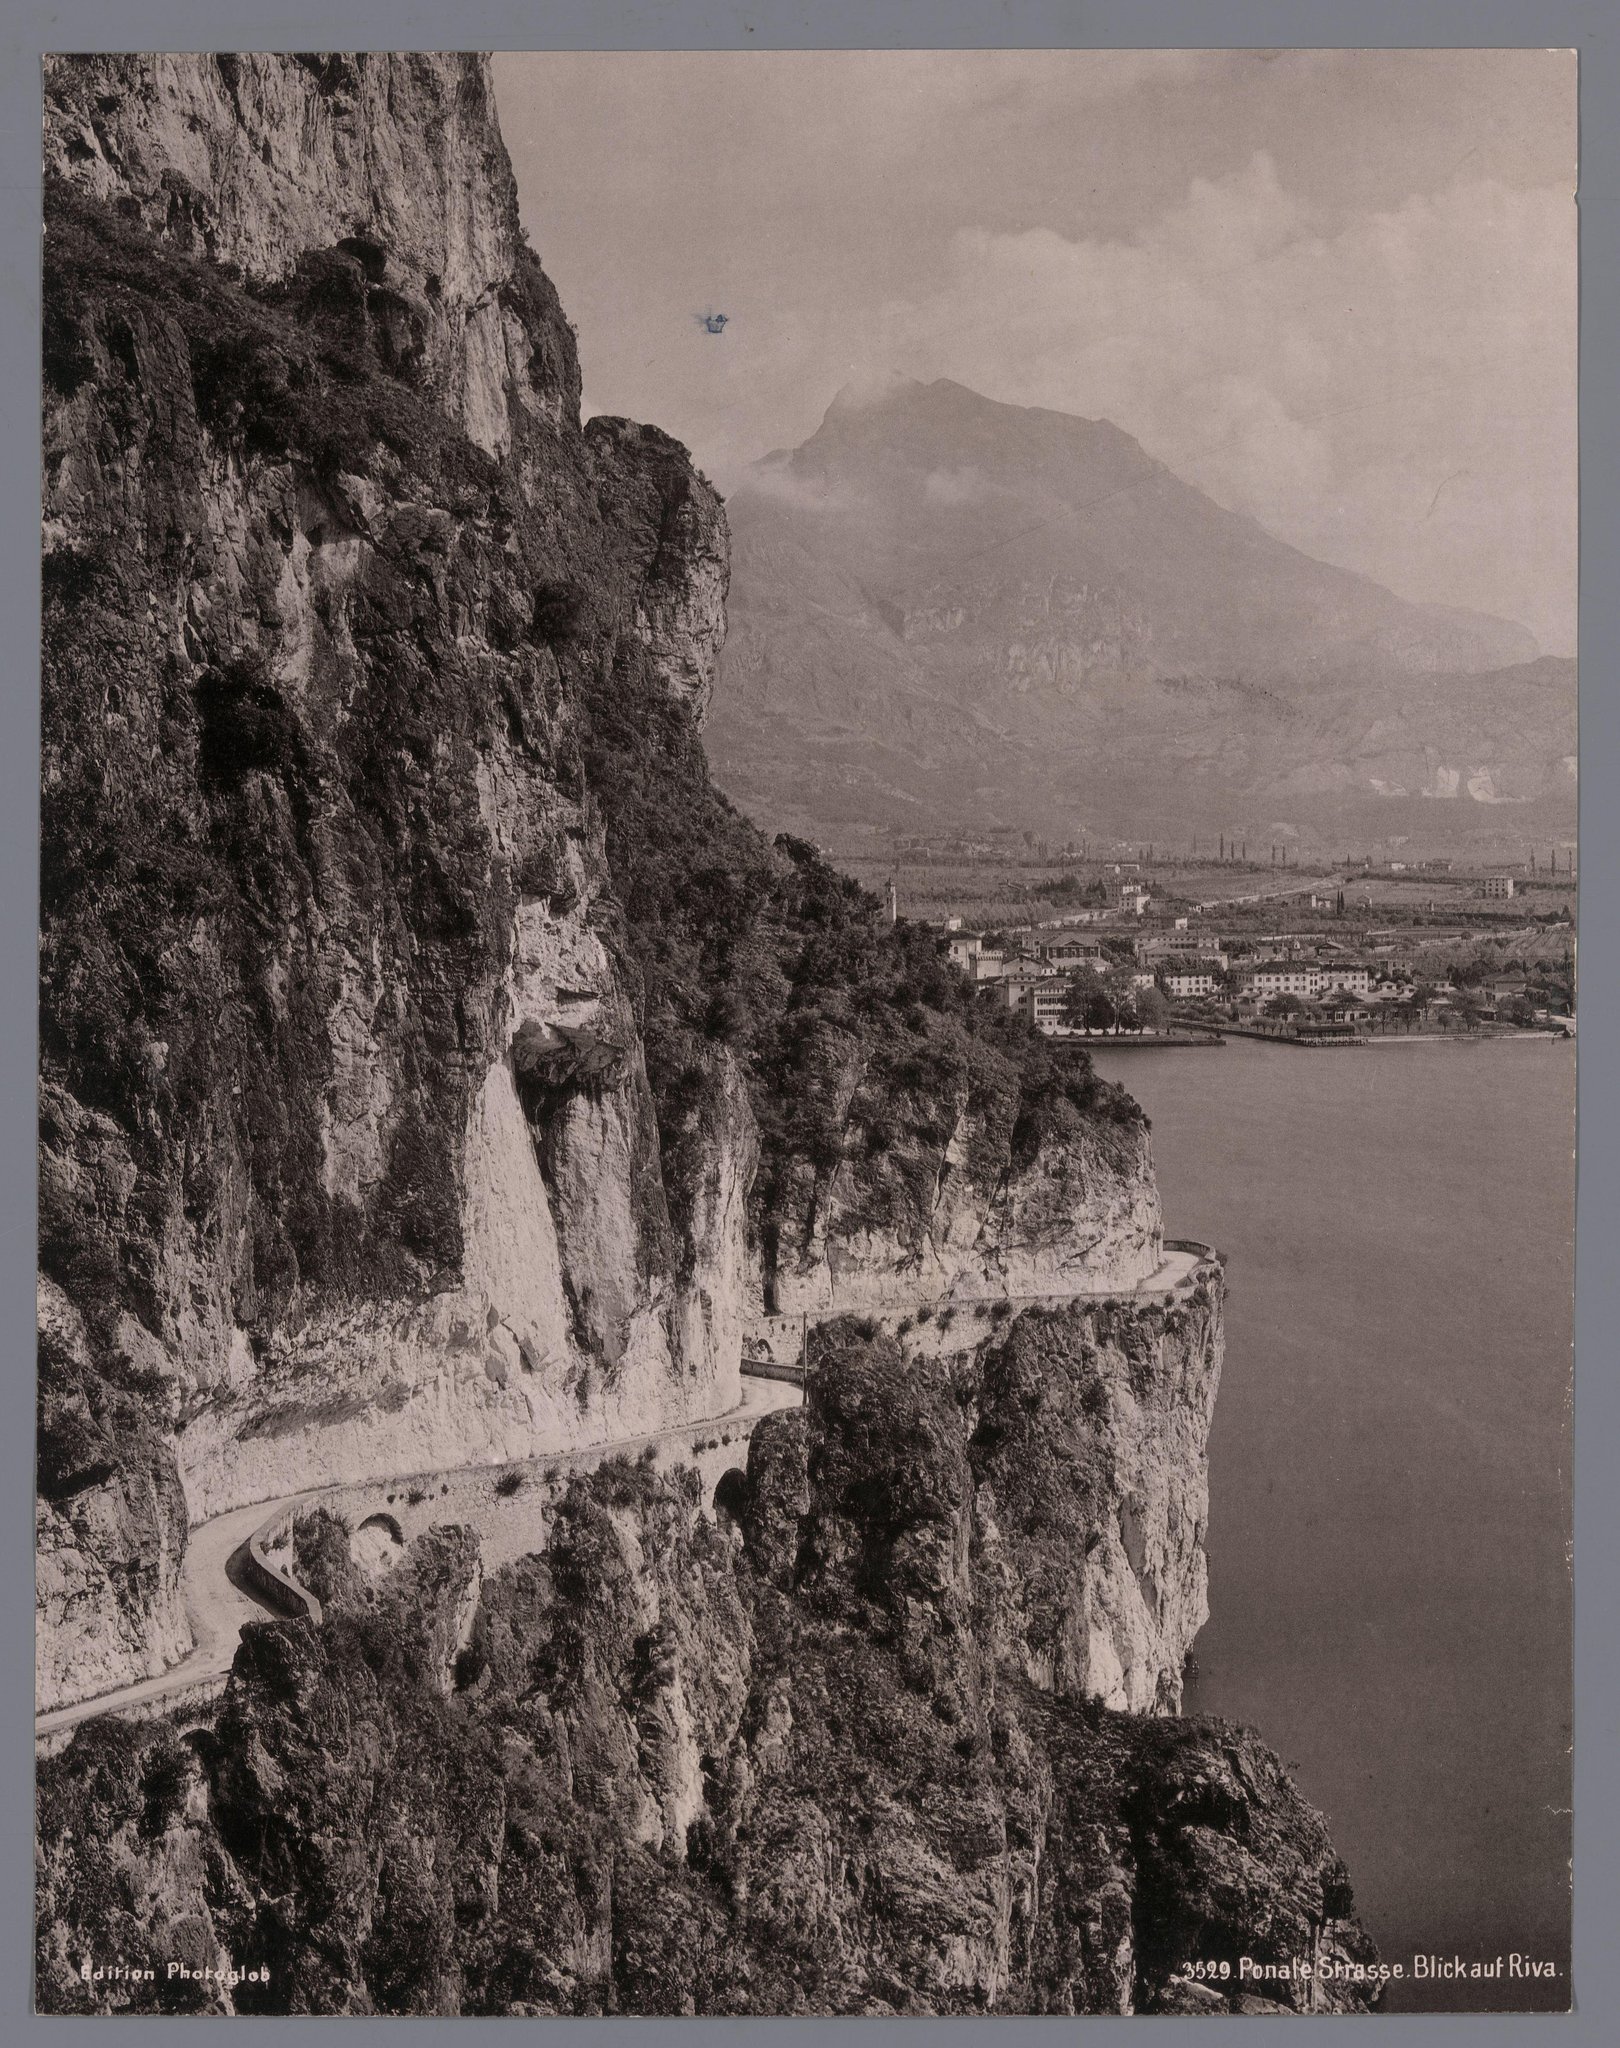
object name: photomechanical print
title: Ponale Strasse, blick auf Riva.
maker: Anonymous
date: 1895-1930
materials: paper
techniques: photograph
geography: trento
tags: lake, road, path, mountains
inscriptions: number: ‘3529.’